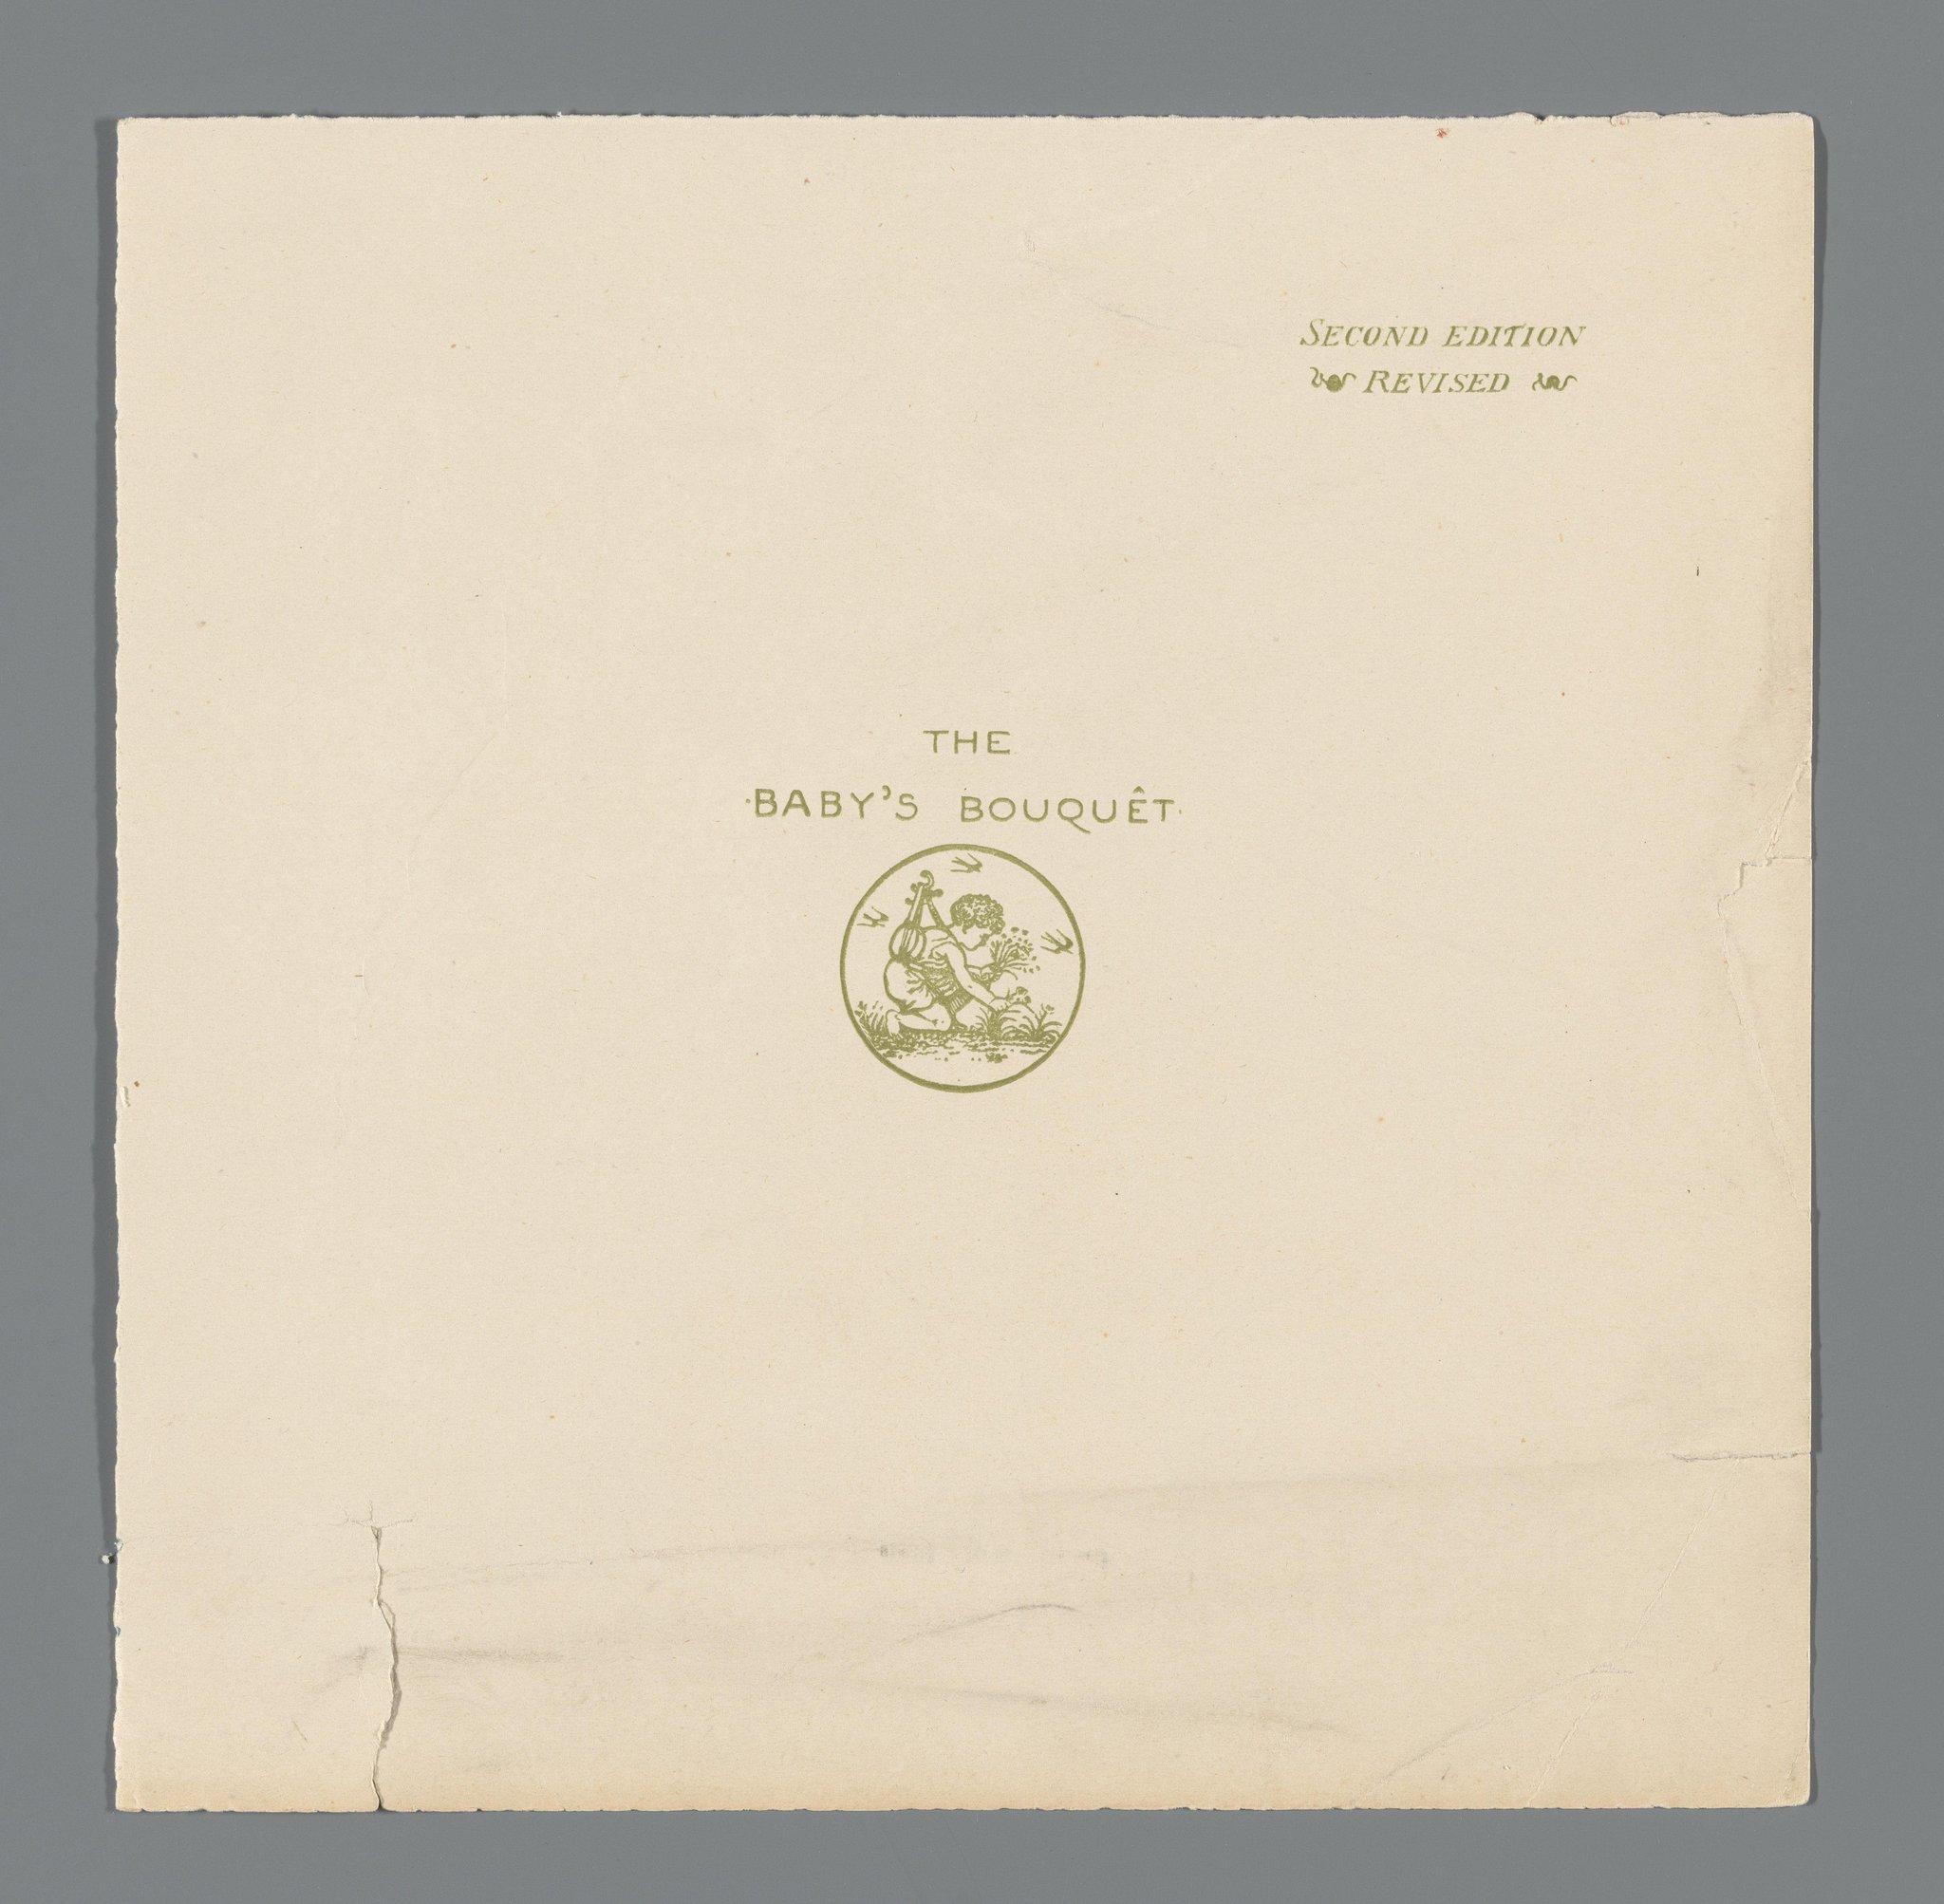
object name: print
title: The baby's bouquêt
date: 1878-1927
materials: paper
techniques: engraving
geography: london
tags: picking flowers, child, lute, and special forms of lute, e.g.: theorbo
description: Prent uit een tweede editie van: The baby's bouquet, a fresh bunch of old rhymes and tunes. Londen: Routledge & Sons, [1878]. Of een latere uitgave.